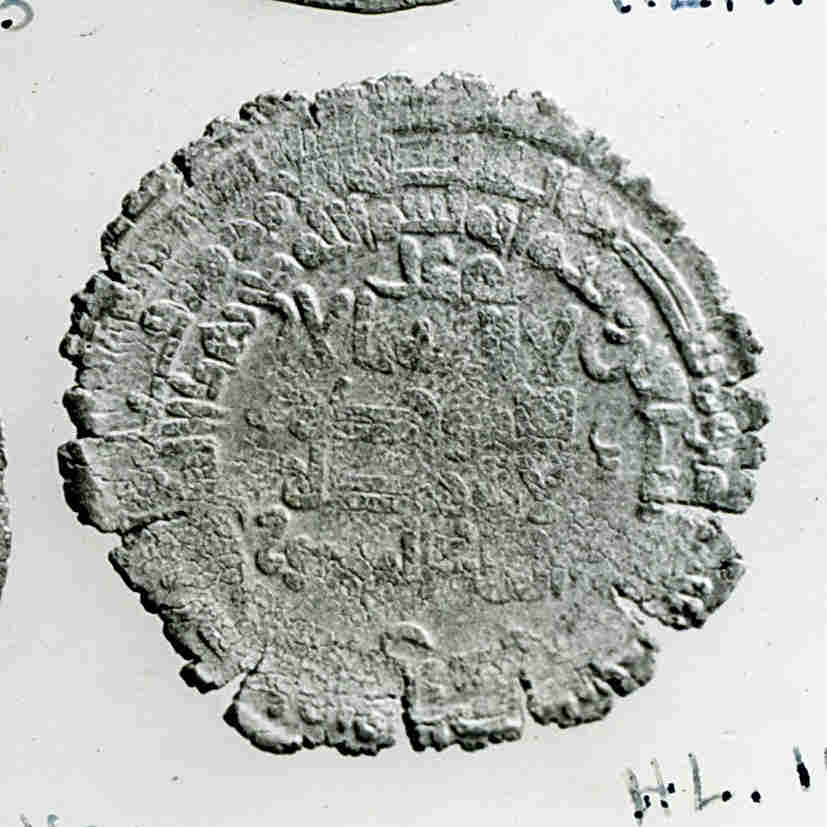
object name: coin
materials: silver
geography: nishapur